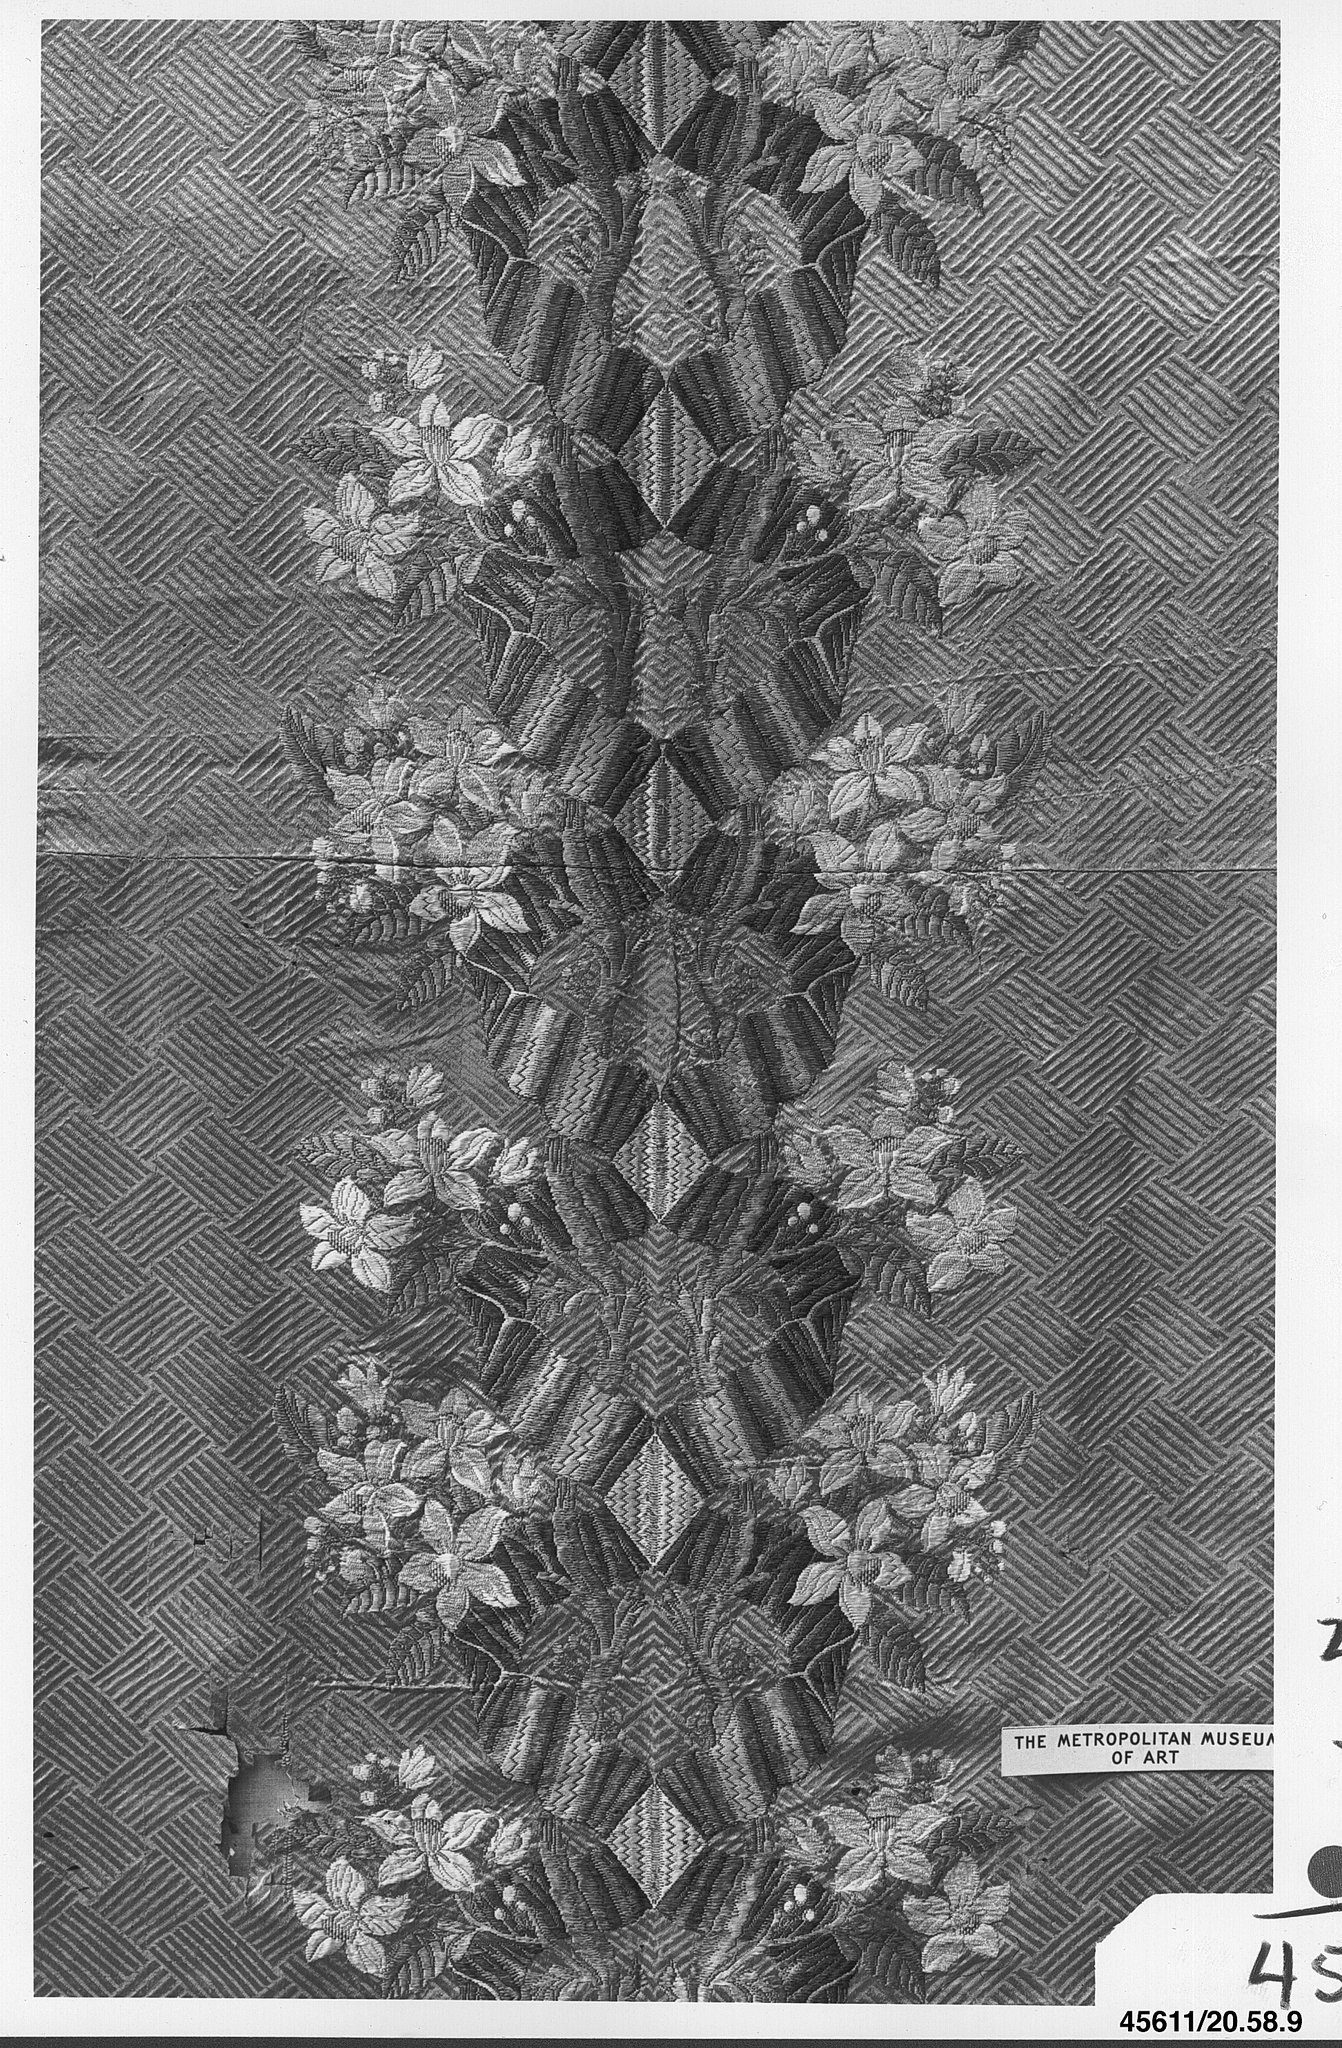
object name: piece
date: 1774-1793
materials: silk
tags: flowers,leaves